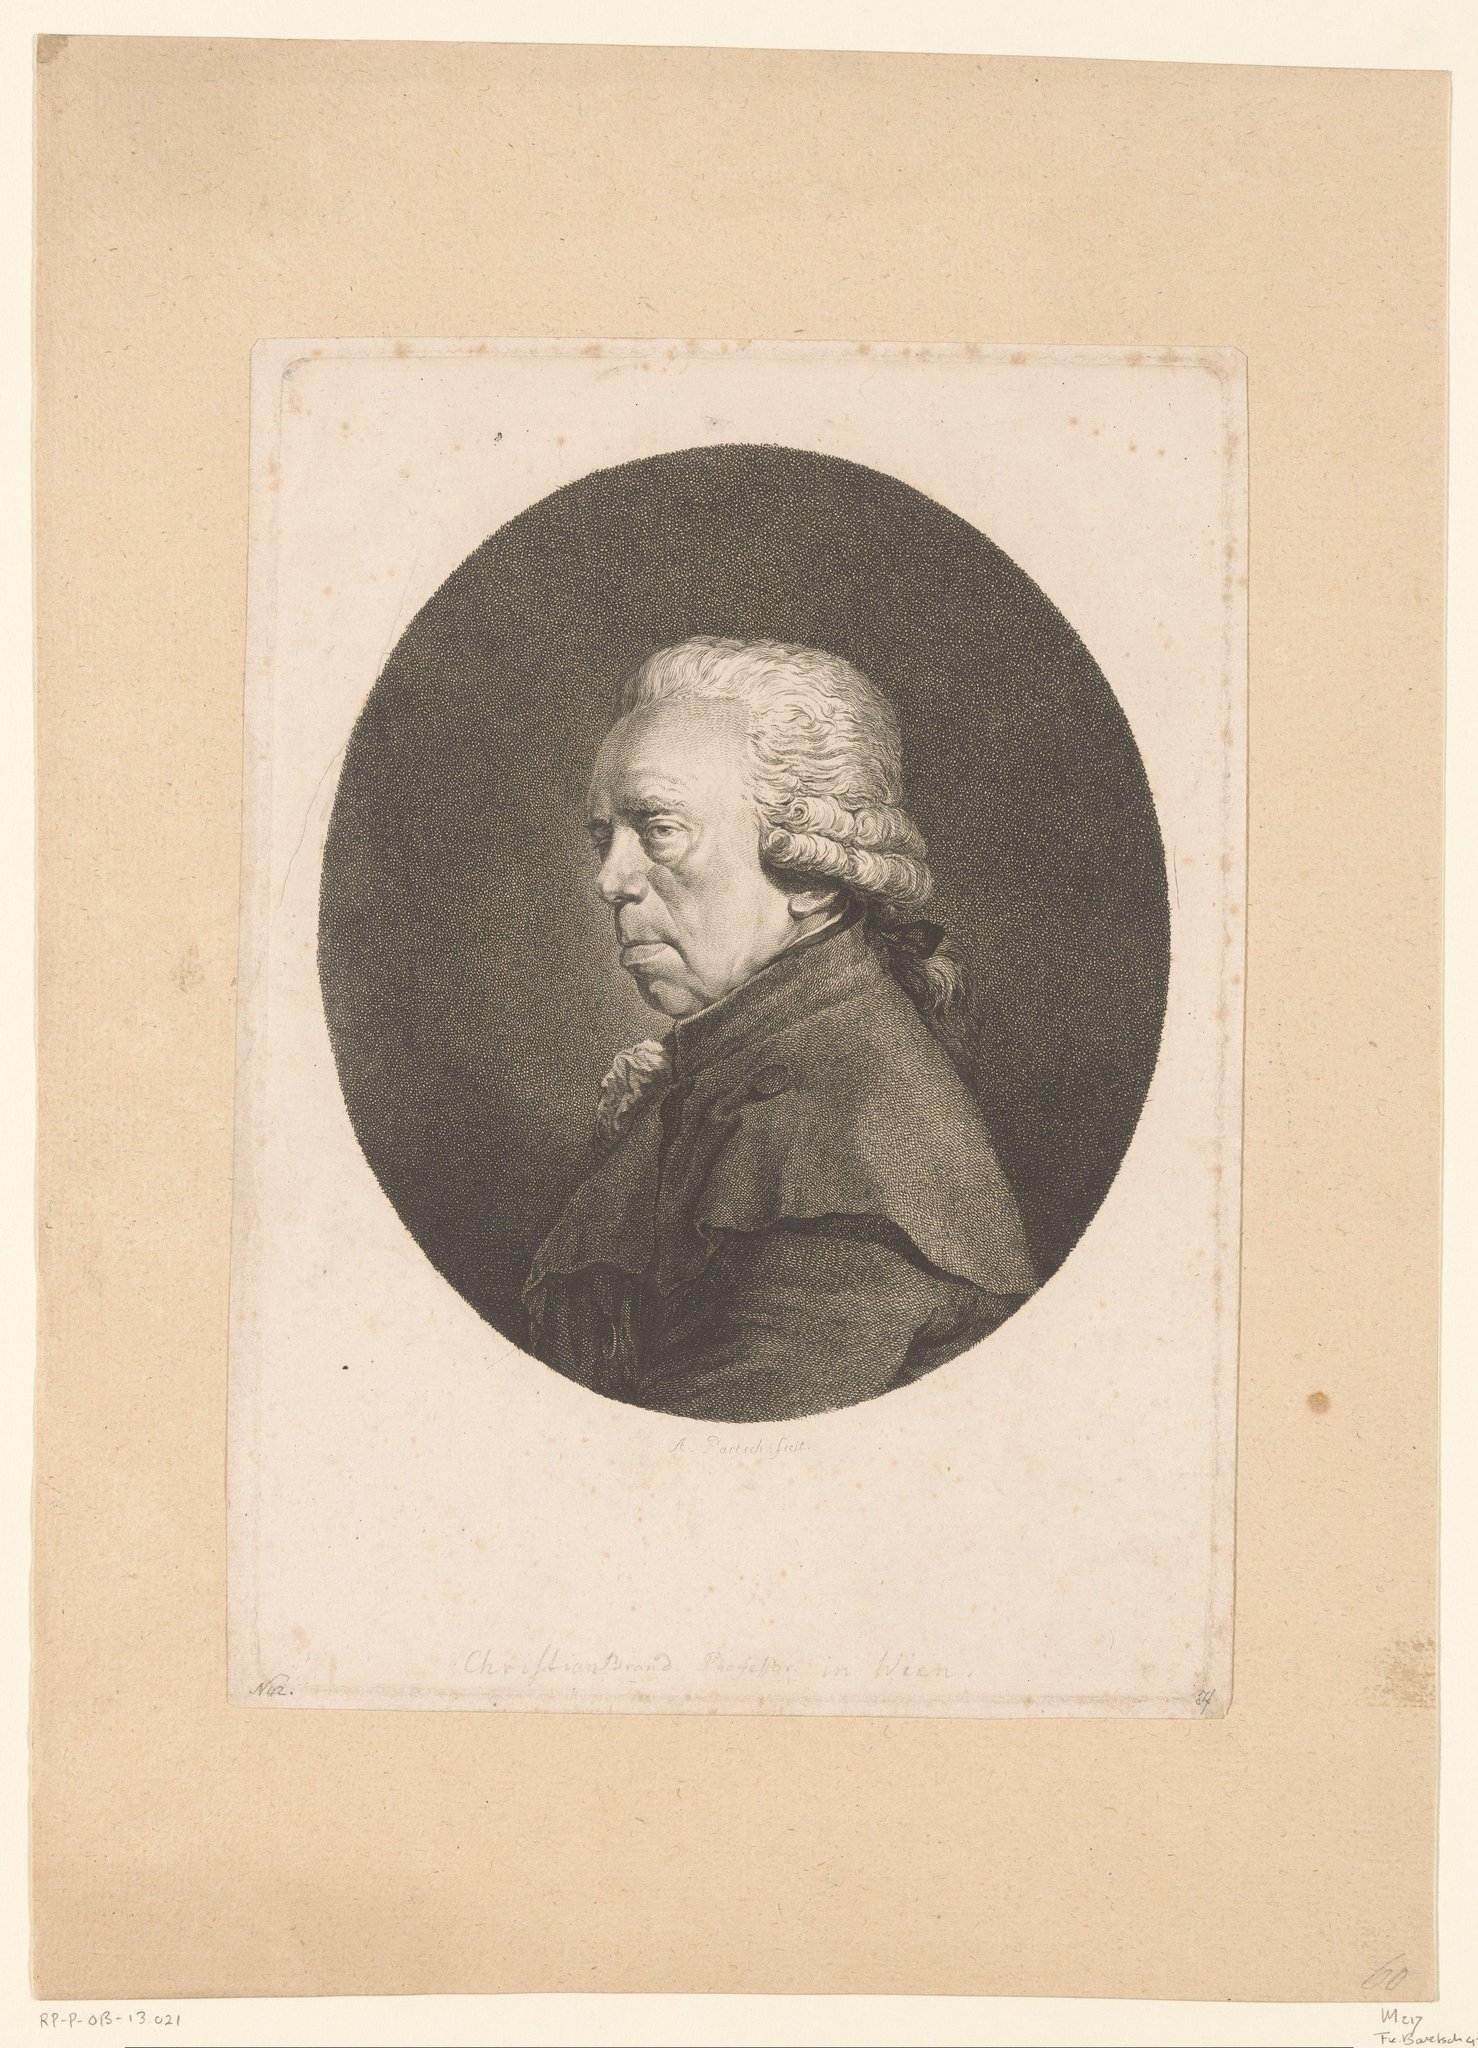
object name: print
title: Portret van Johann Christian Brand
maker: adam von bartsch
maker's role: print maker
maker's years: 1757-1821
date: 1793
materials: paper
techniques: etching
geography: vienna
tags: vienna, painter, print maker, draughtsman, johann christian brand, historical persons, portrait, self-portrait of artist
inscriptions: collector's mark: Lugt 2228